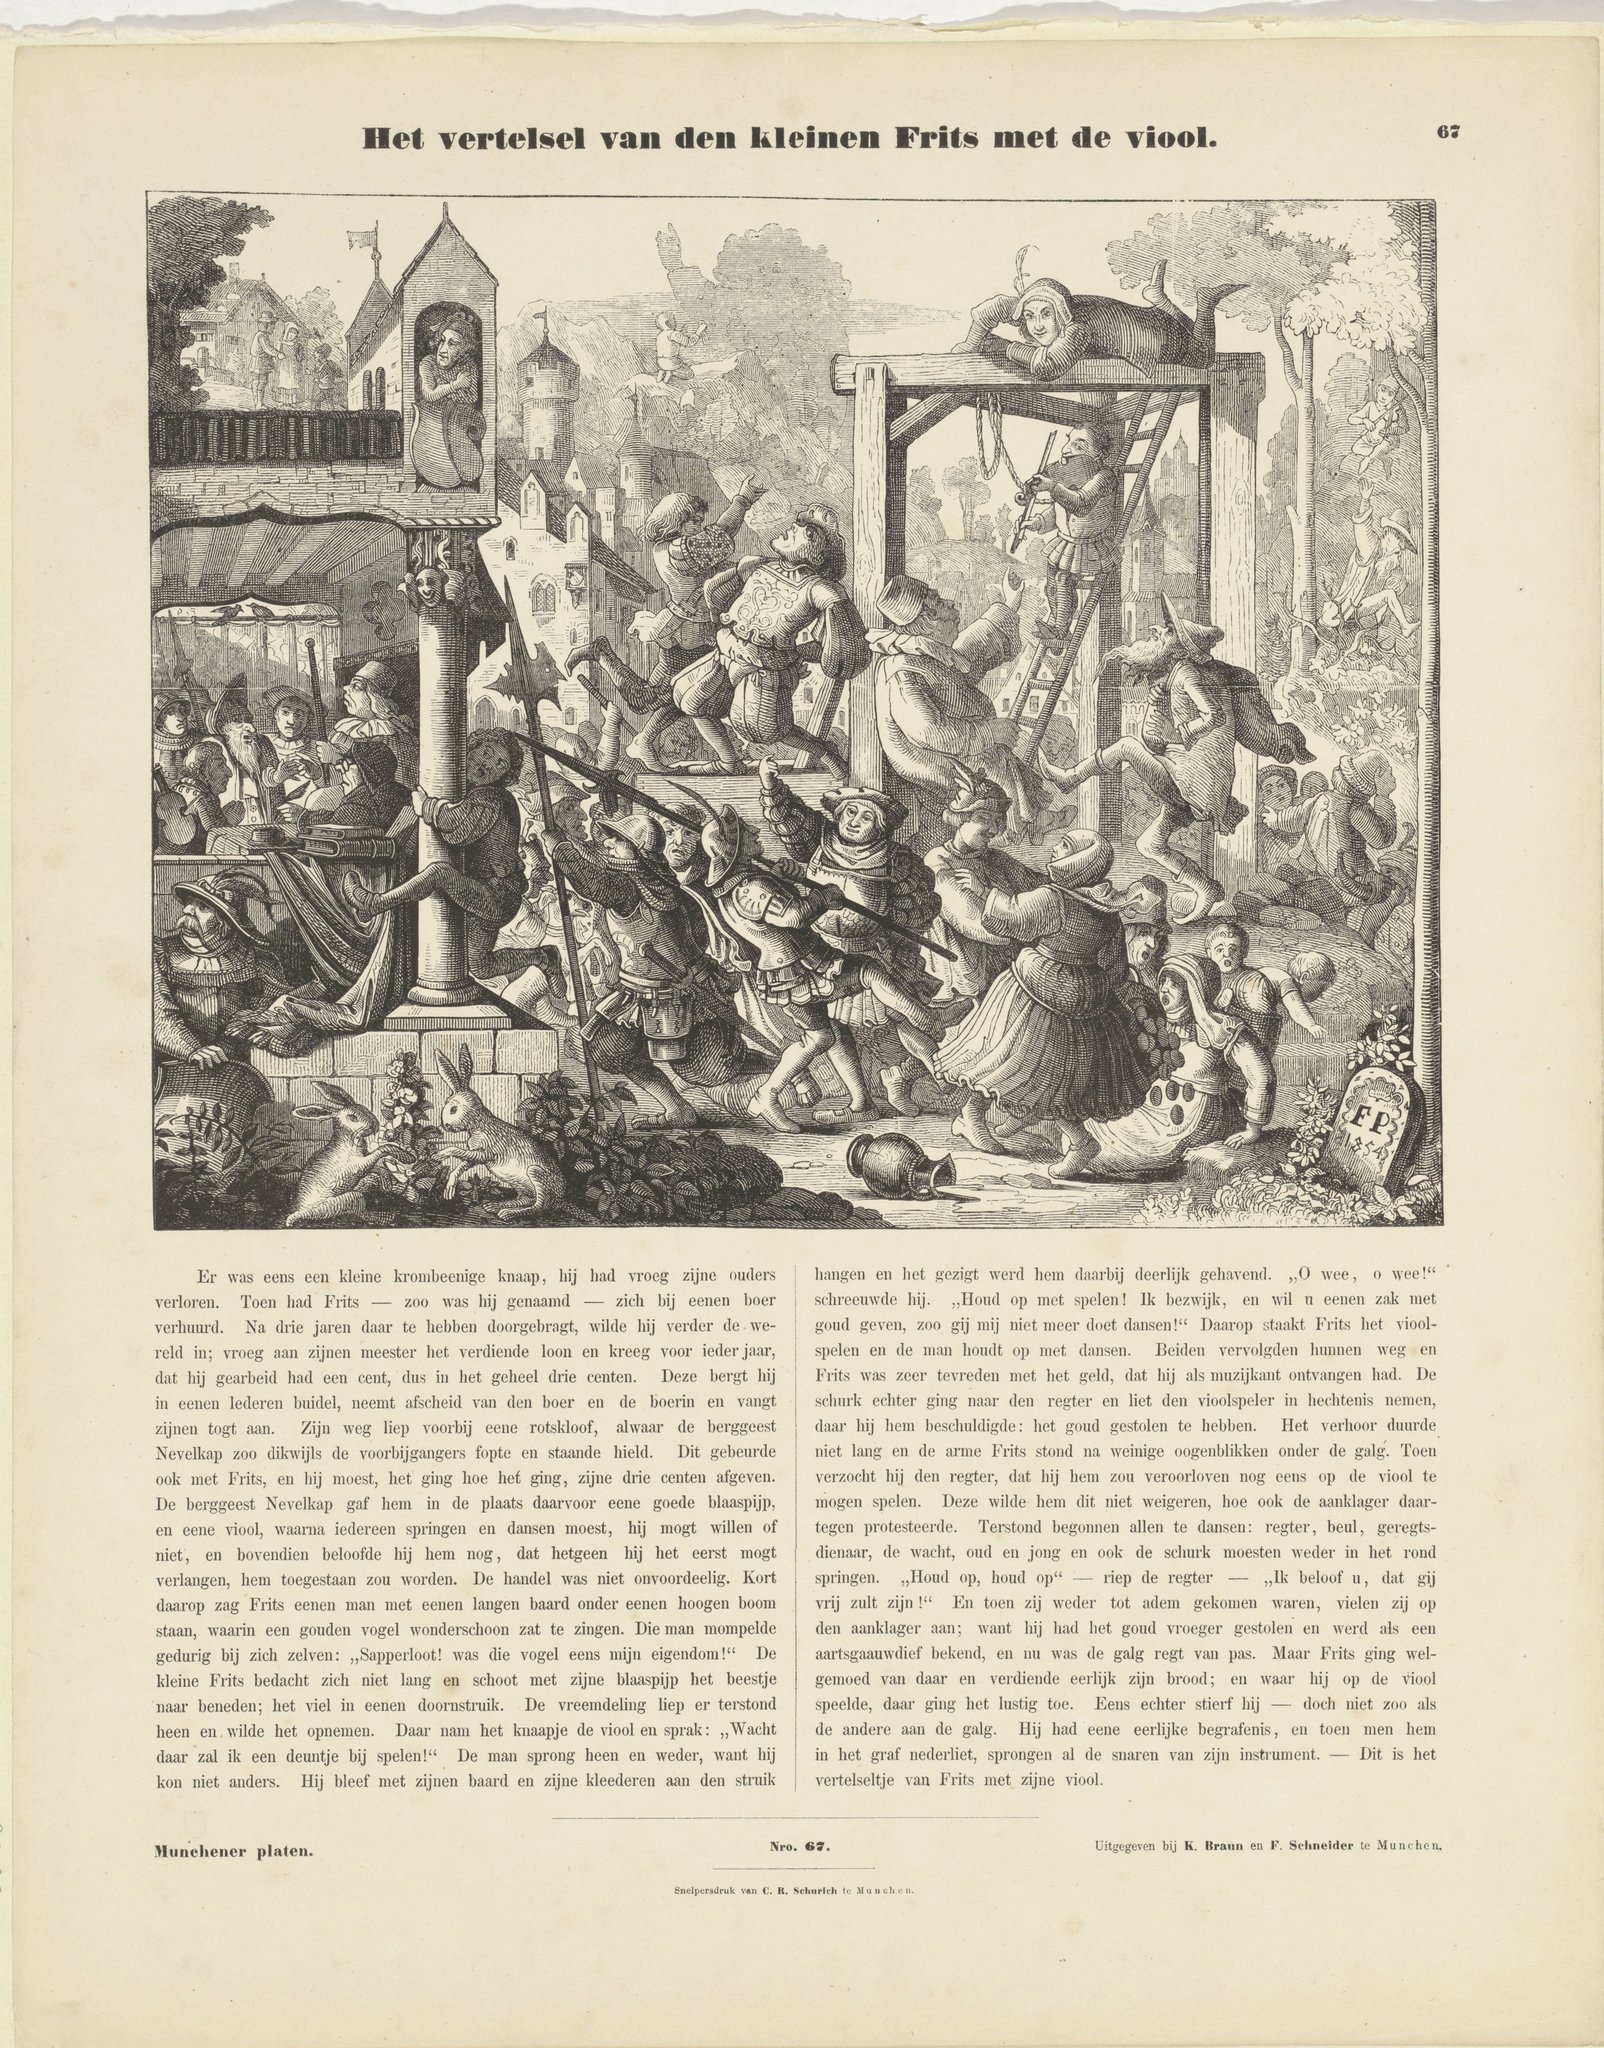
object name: print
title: Het vertelsel van den kleinen Frits met de viool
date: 1854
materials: paper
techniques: letterpress printing, engraving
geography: munich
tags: instruments of torture, execution or punishment: gallows, magic, supernaturalism, occultism, violin, fiddle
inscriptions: collector's mark: Lugt 2760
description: Scène uit het verhaal van Frits zijn viool, over hoe Frits met zijn toverviool zijn eigen leven redt. Onder de afbeelding een tekst in twee kolommen. Genummerd midden onder: Nro. 67. Genummerd rechtsboven: 67.